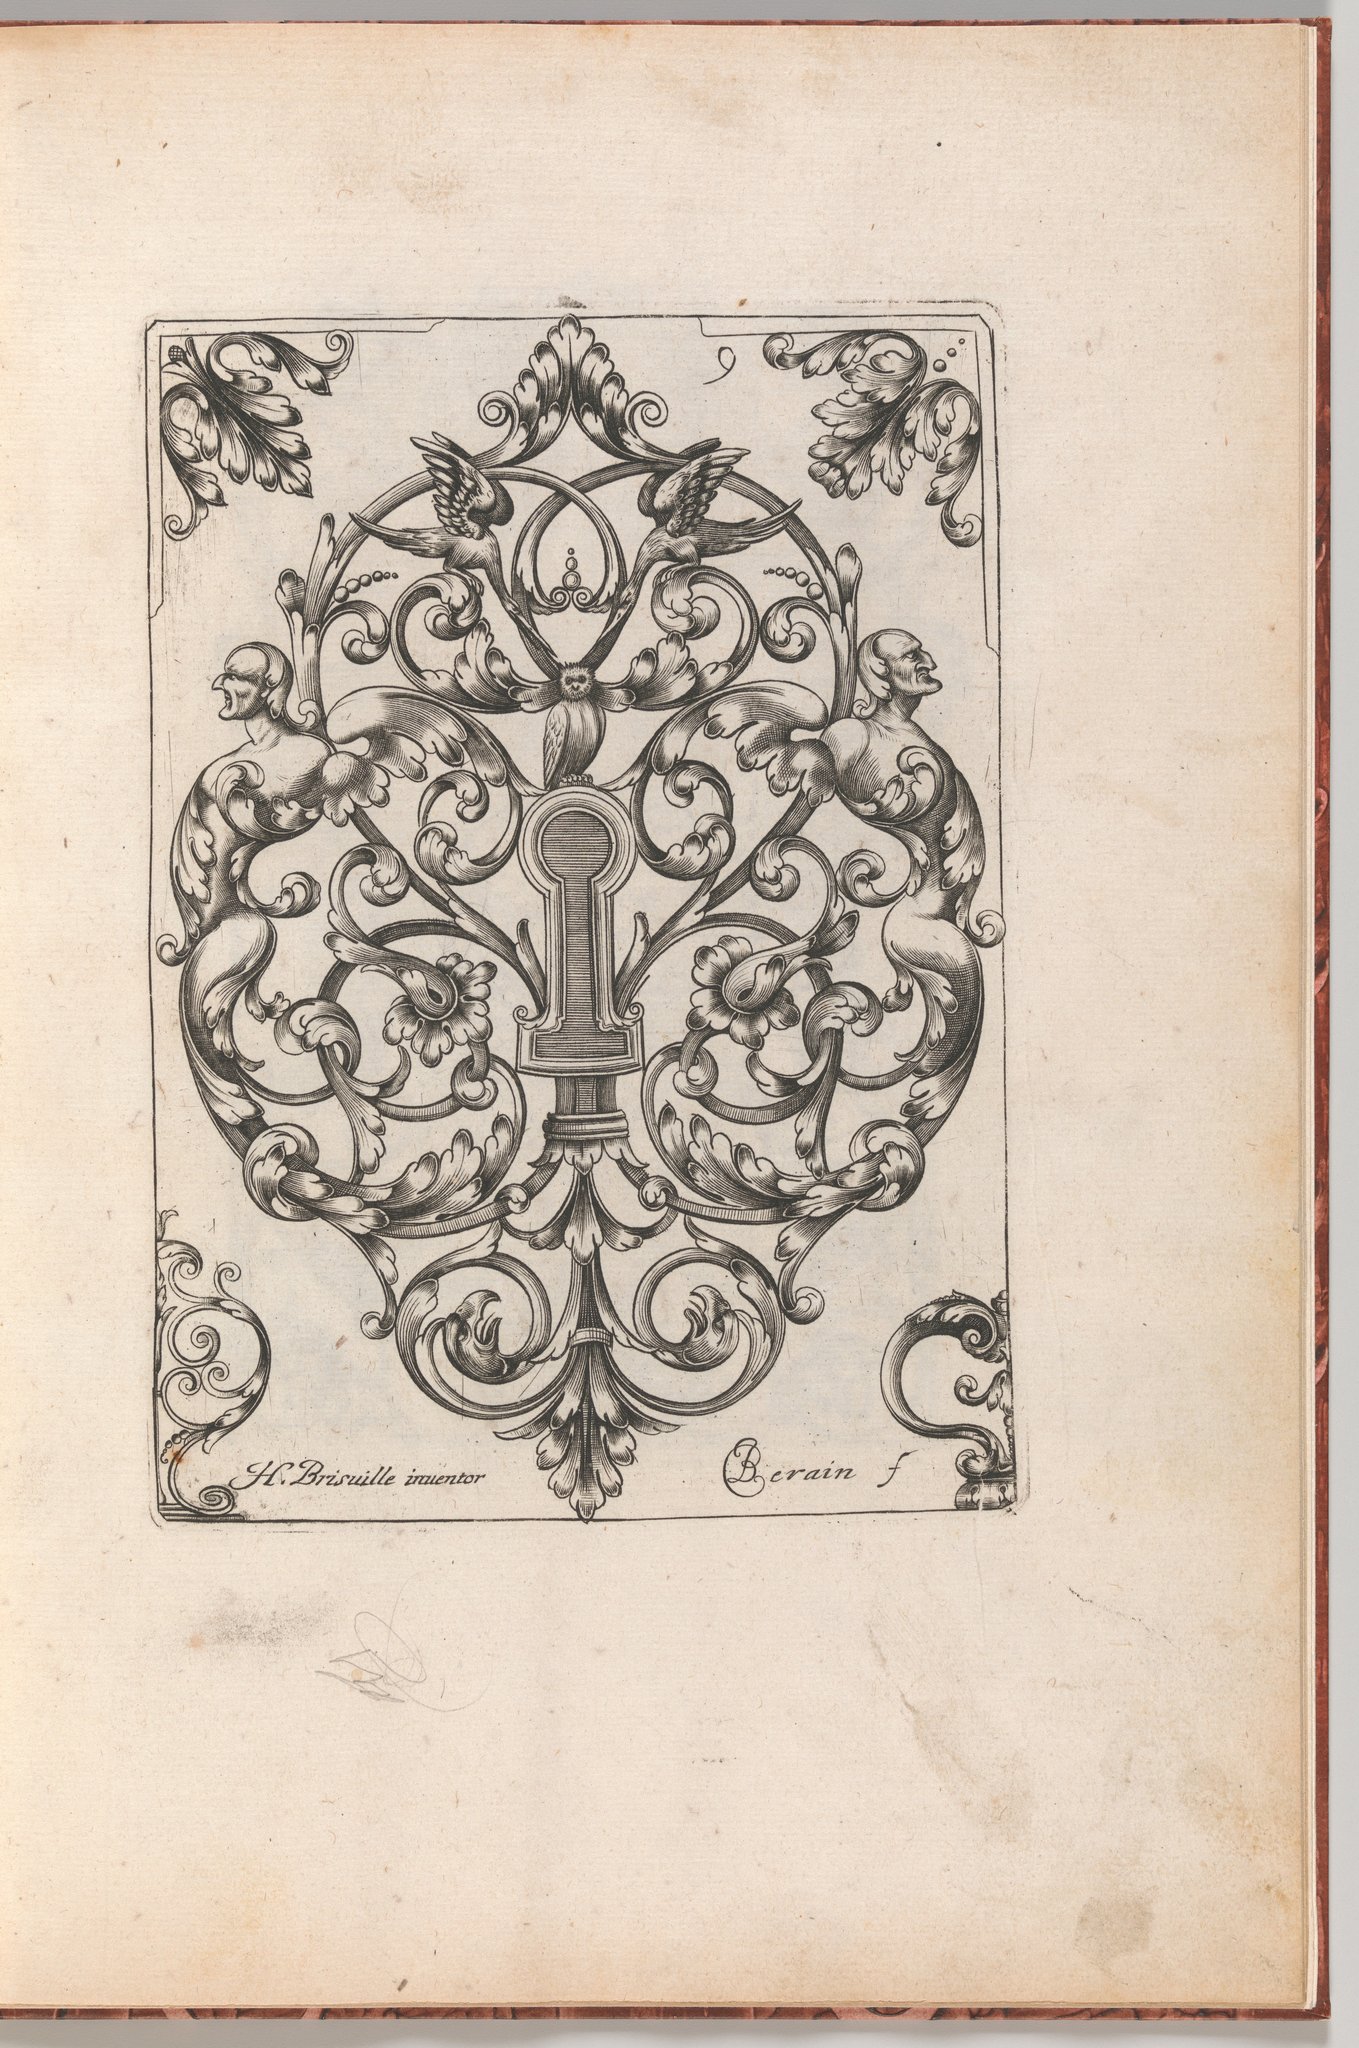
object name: album print ornament architecture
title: Diverses Pieces de Serruriers, page 10 (recto)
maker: jean berain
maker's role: artist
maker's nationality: french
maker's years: 1640-1711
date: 1663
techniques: engraving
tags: birds,owls,flowers